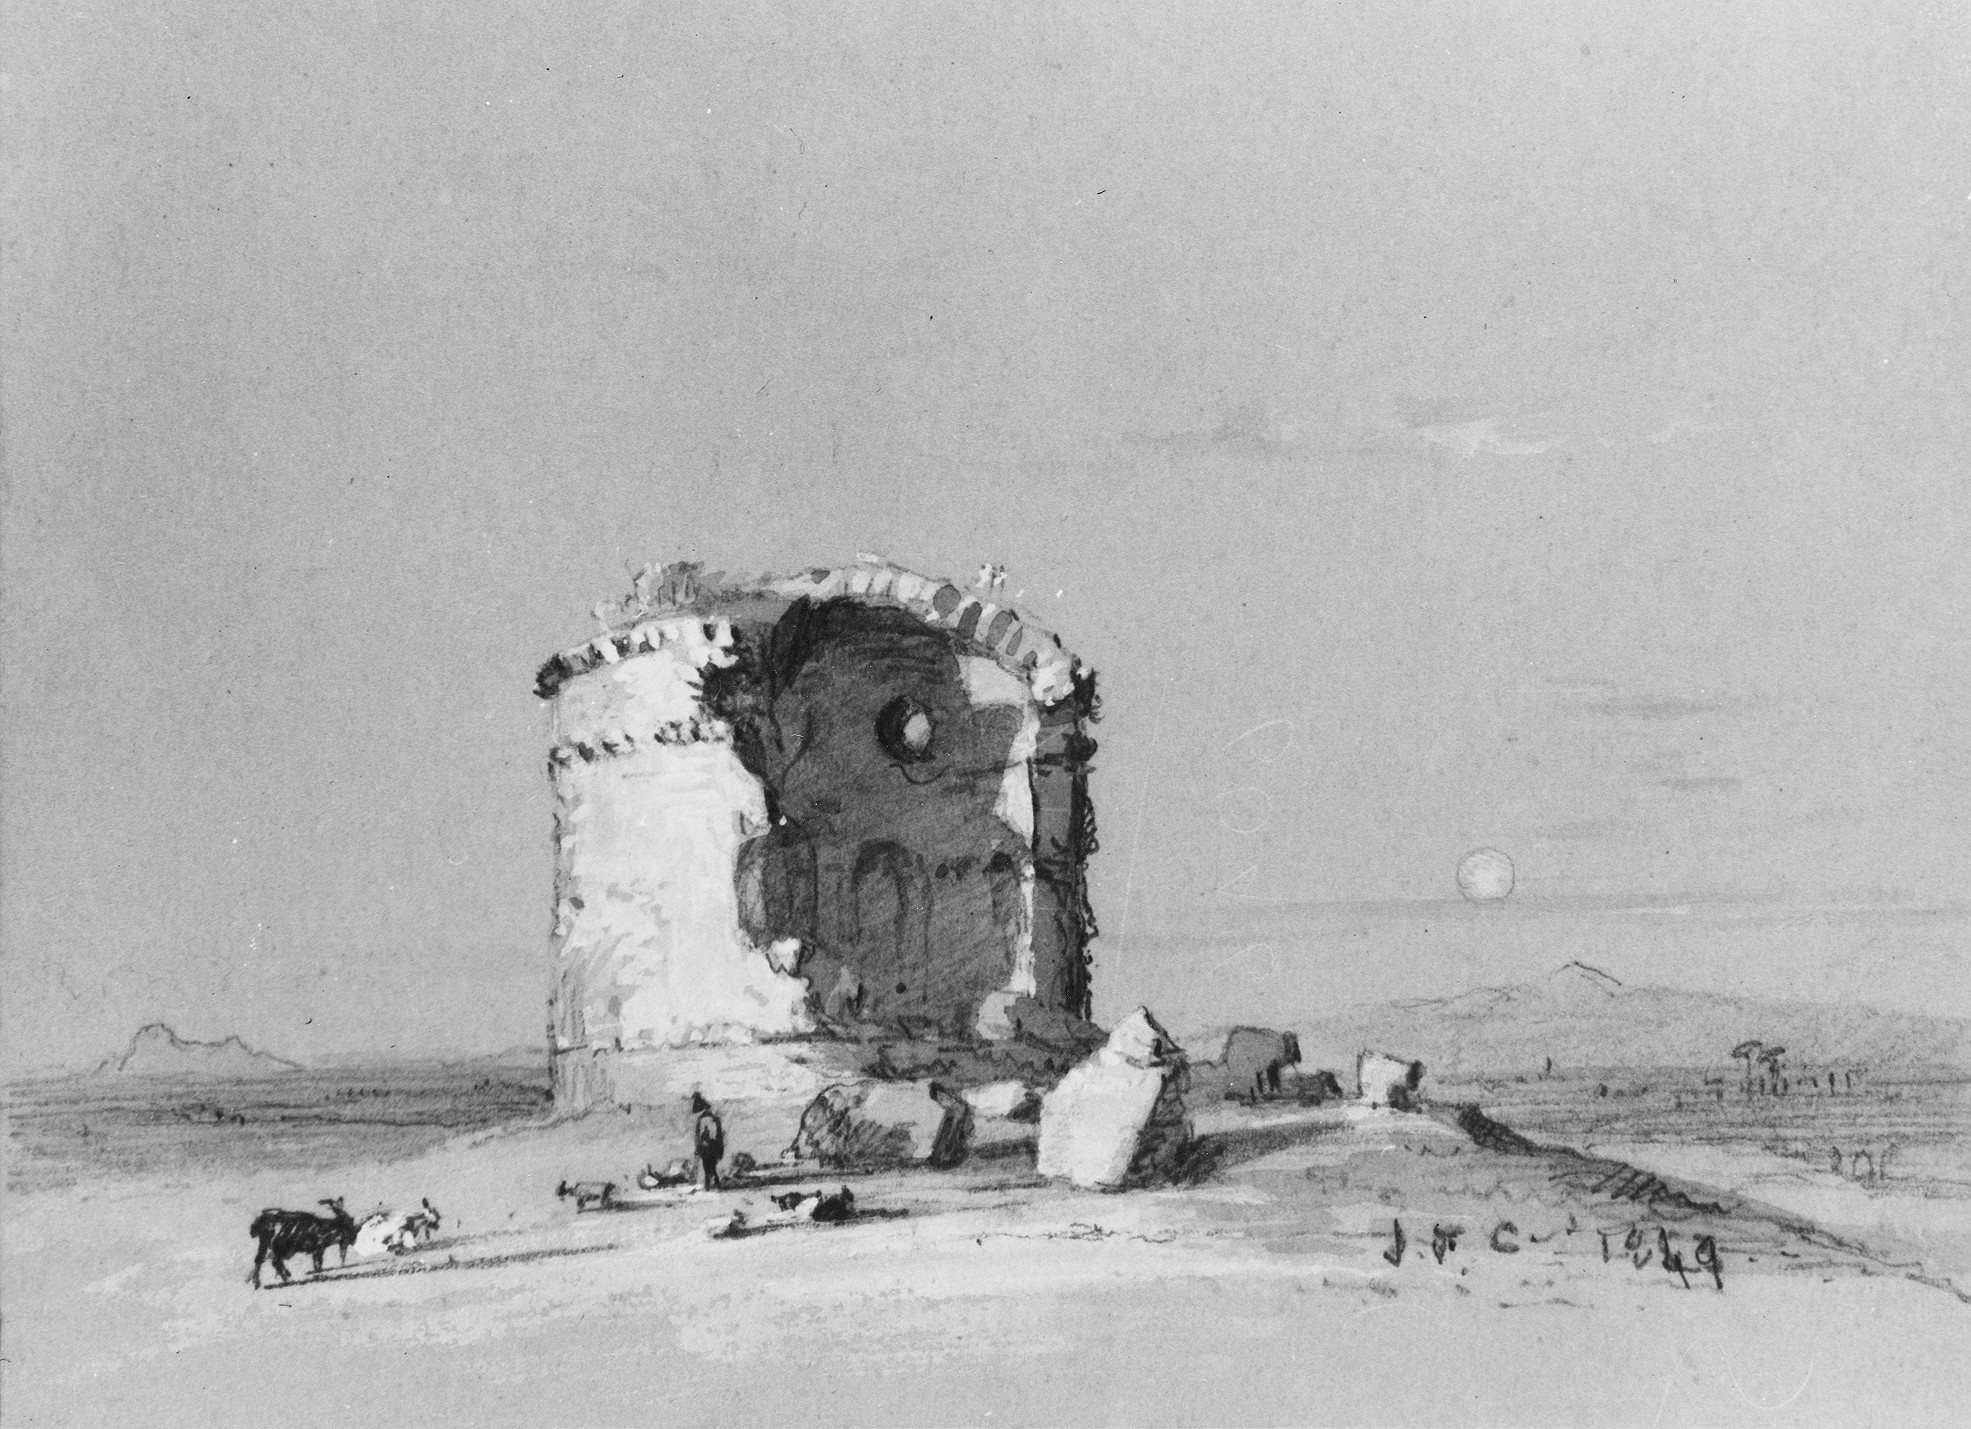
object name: drawing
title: Torre dei Schiavi, The Roman Campagna (from Cropsey Album)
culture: american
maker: jasper francis cropsey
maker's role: artist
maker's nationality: american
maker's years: 1823-1900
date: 1853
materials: gouache, graphite, ink, paper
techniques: wash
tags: towers,ruins